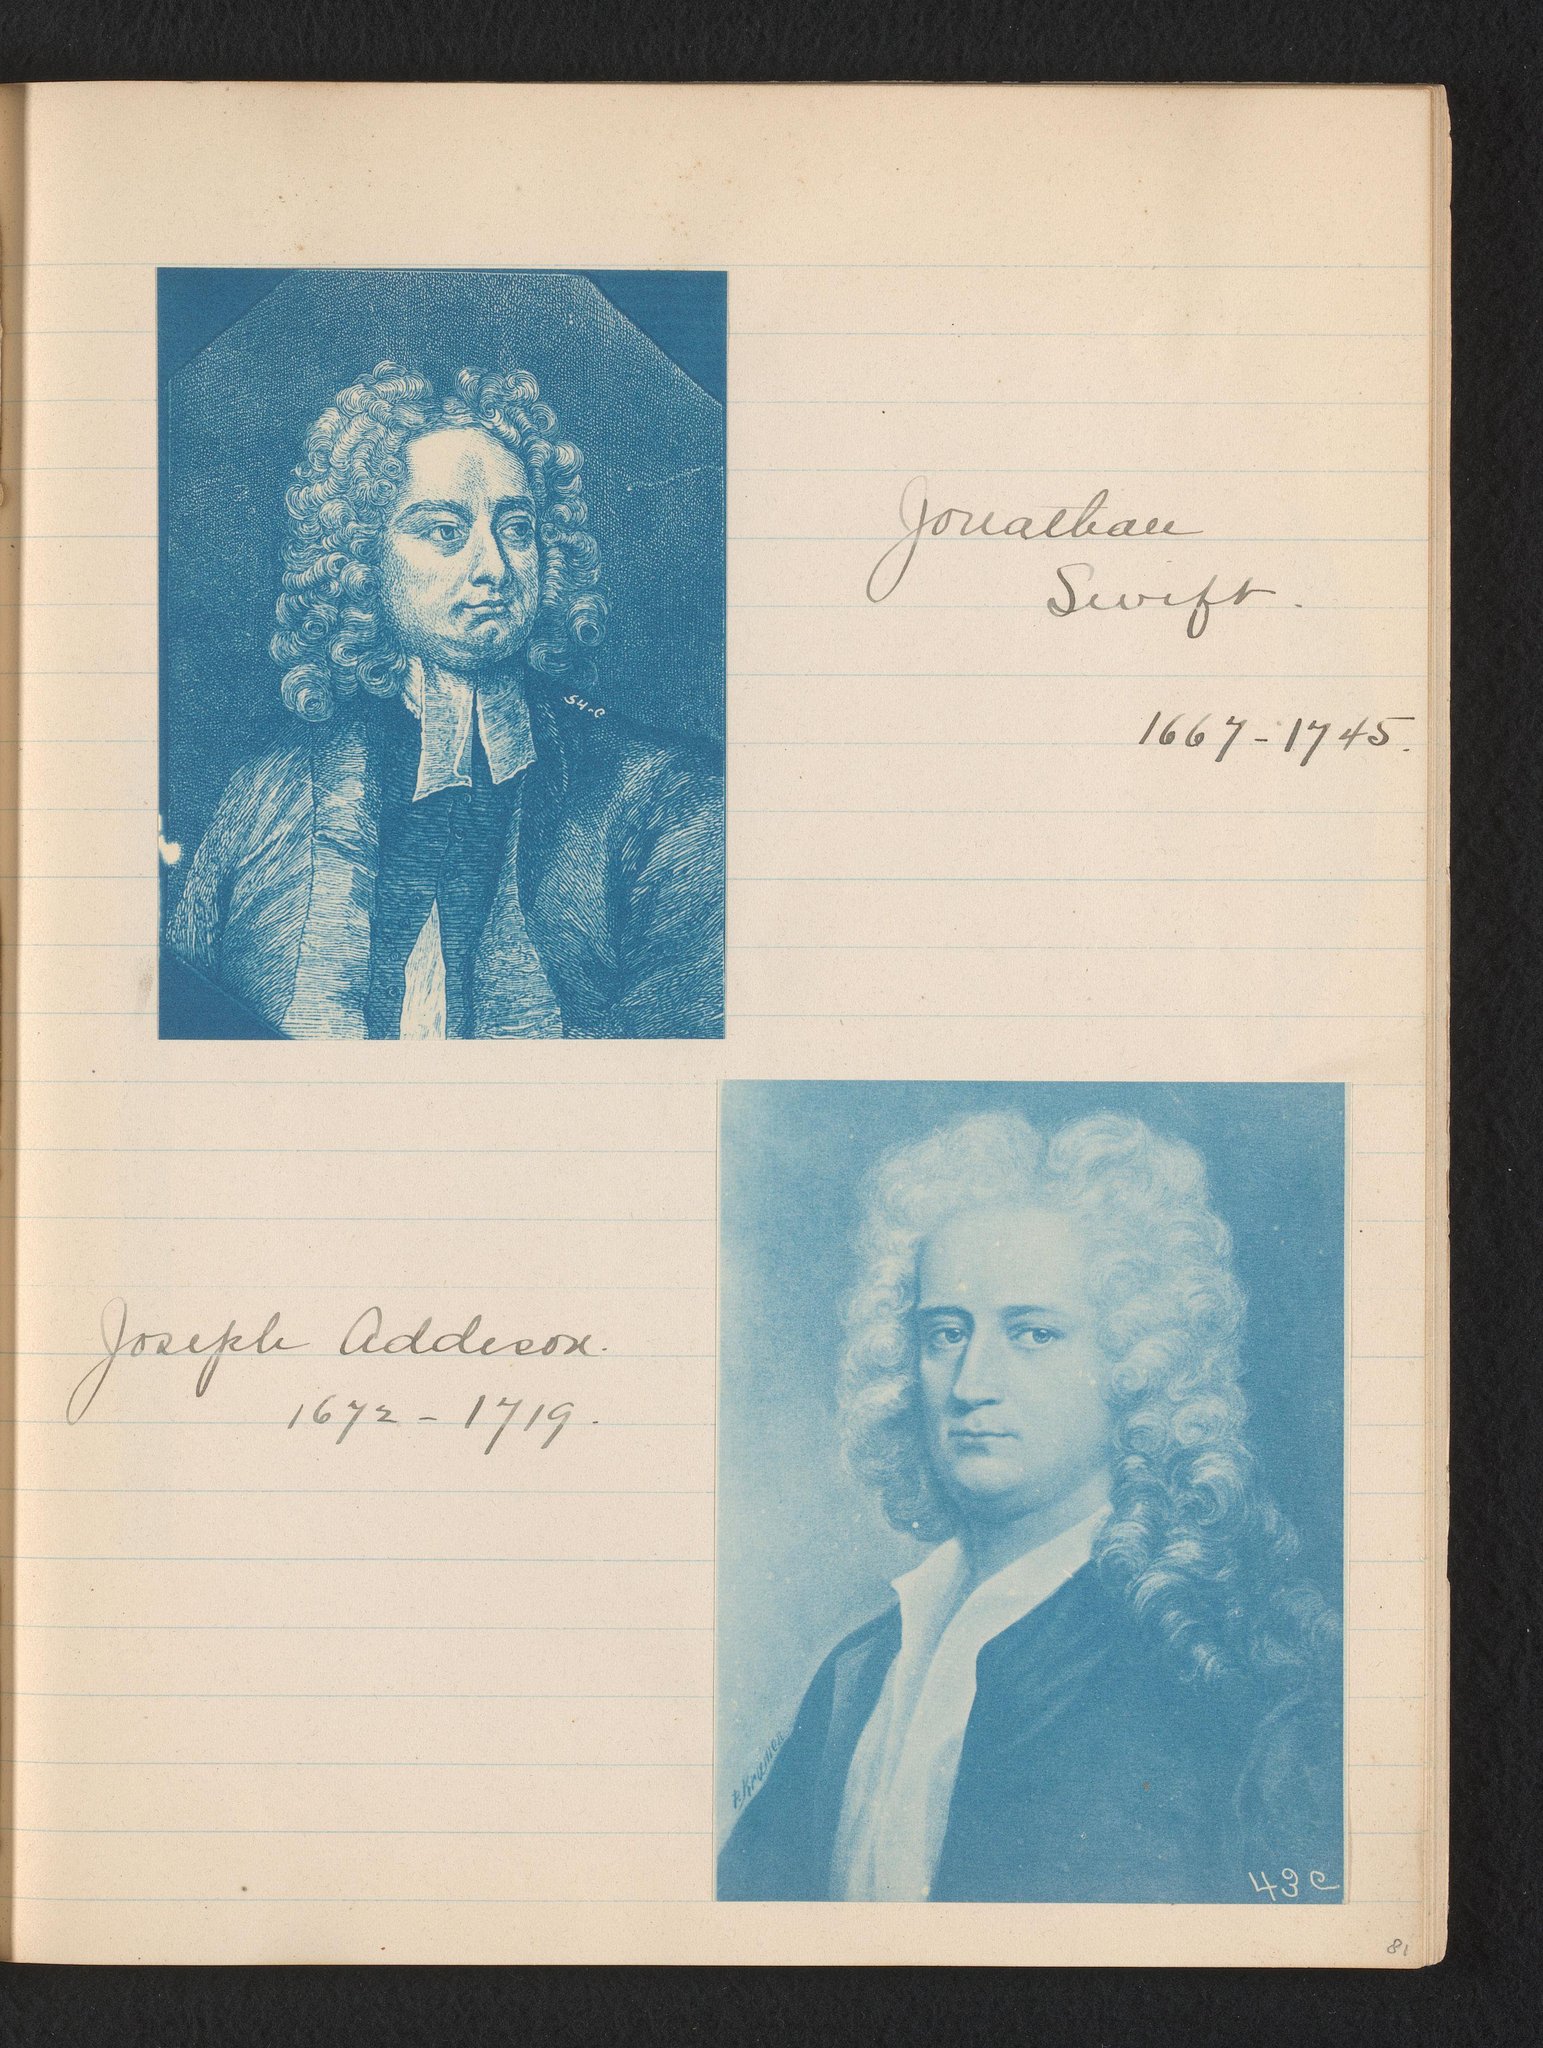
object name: reproduction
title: Twee fotoreproducties van een prent en een schilderij van portretten van Jonathan Swift en Joseph Addison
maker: Anonymous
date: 1901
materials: paper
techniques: cyanotype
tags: politician, joseph addison, historical persons, writer, poet, author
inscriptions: inscription: ‘Jonathan/ Swift/ 1667-1745/ Joseph Addison/ 1672-1719.’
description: Deze foto's maken deel uit van een album.